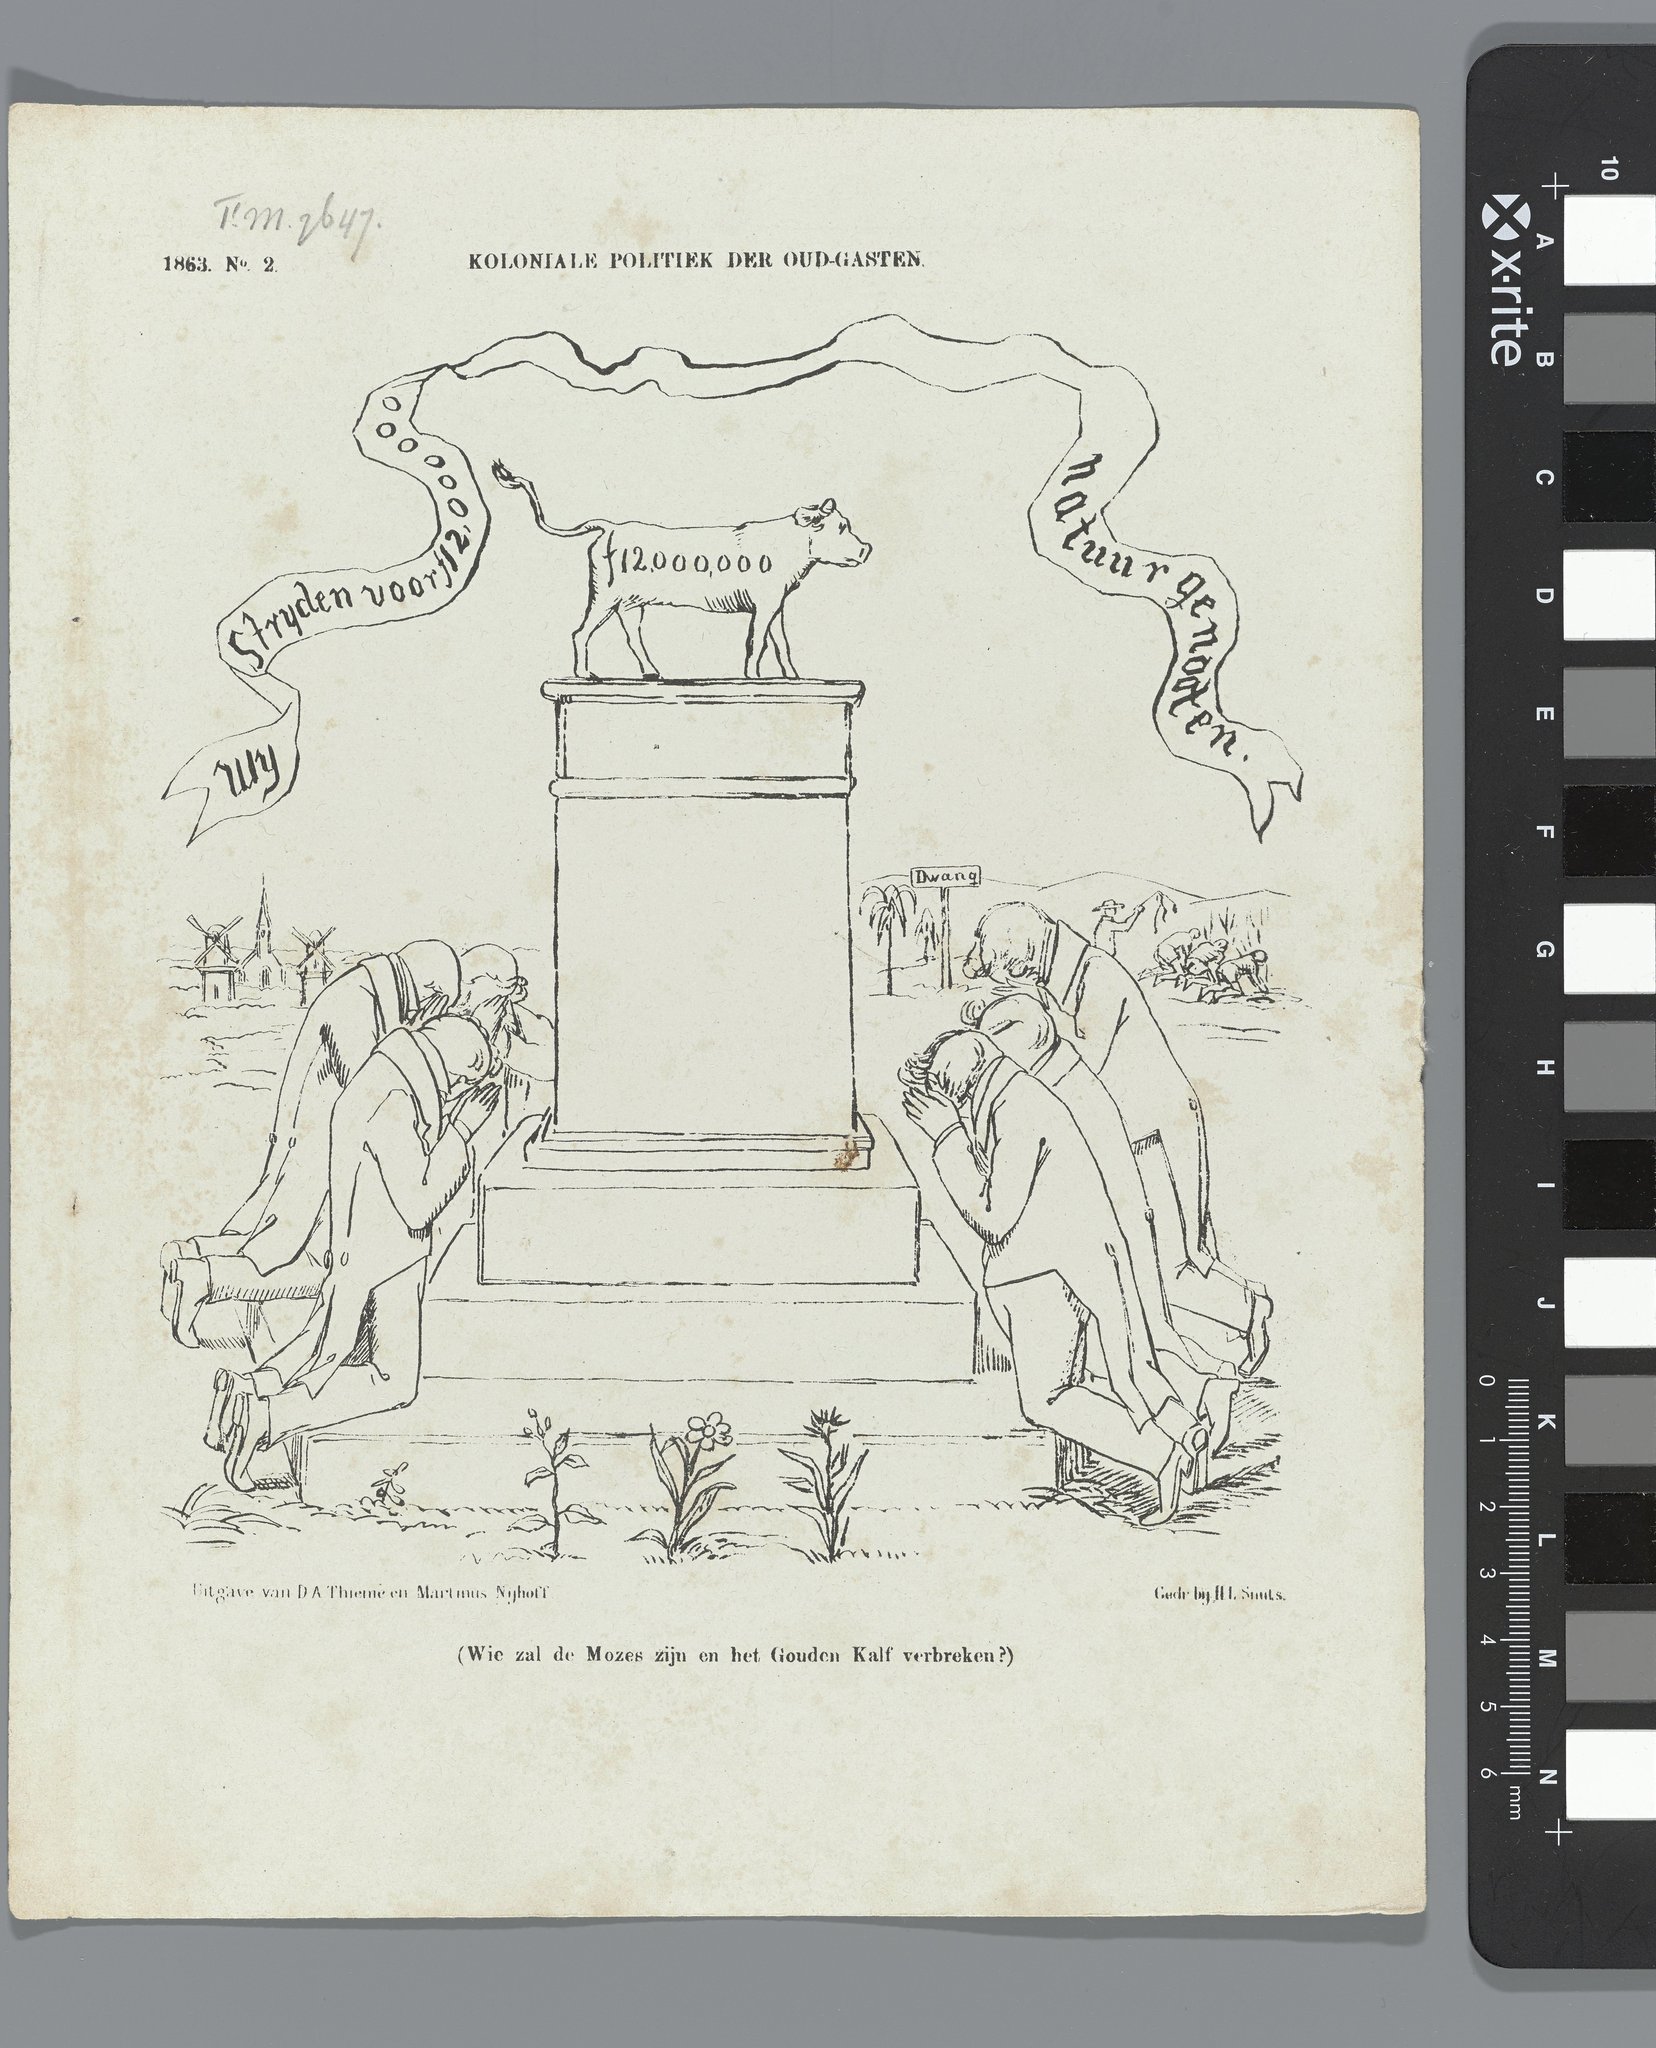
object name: print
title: Koloniale politiek der oud-gasten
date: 1863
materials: paper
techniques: lithograph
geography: netherlands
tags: the adoration of the golden calf ~ aaron (exodus 32:1-19), slavery; serfs and enslaved persons, dutch east indies, the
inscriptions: collector's mark: Lugt 2228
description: Spotprent over de bijdragen van Oost-Indië aan de Nederlandse schatkist. Oud-Indiëgangers knielen rondom het Gouden Kalf. Plaat verschenen bij het weekblad De Nederlandsche Spectator, nr. 2, 10 januari 1863.